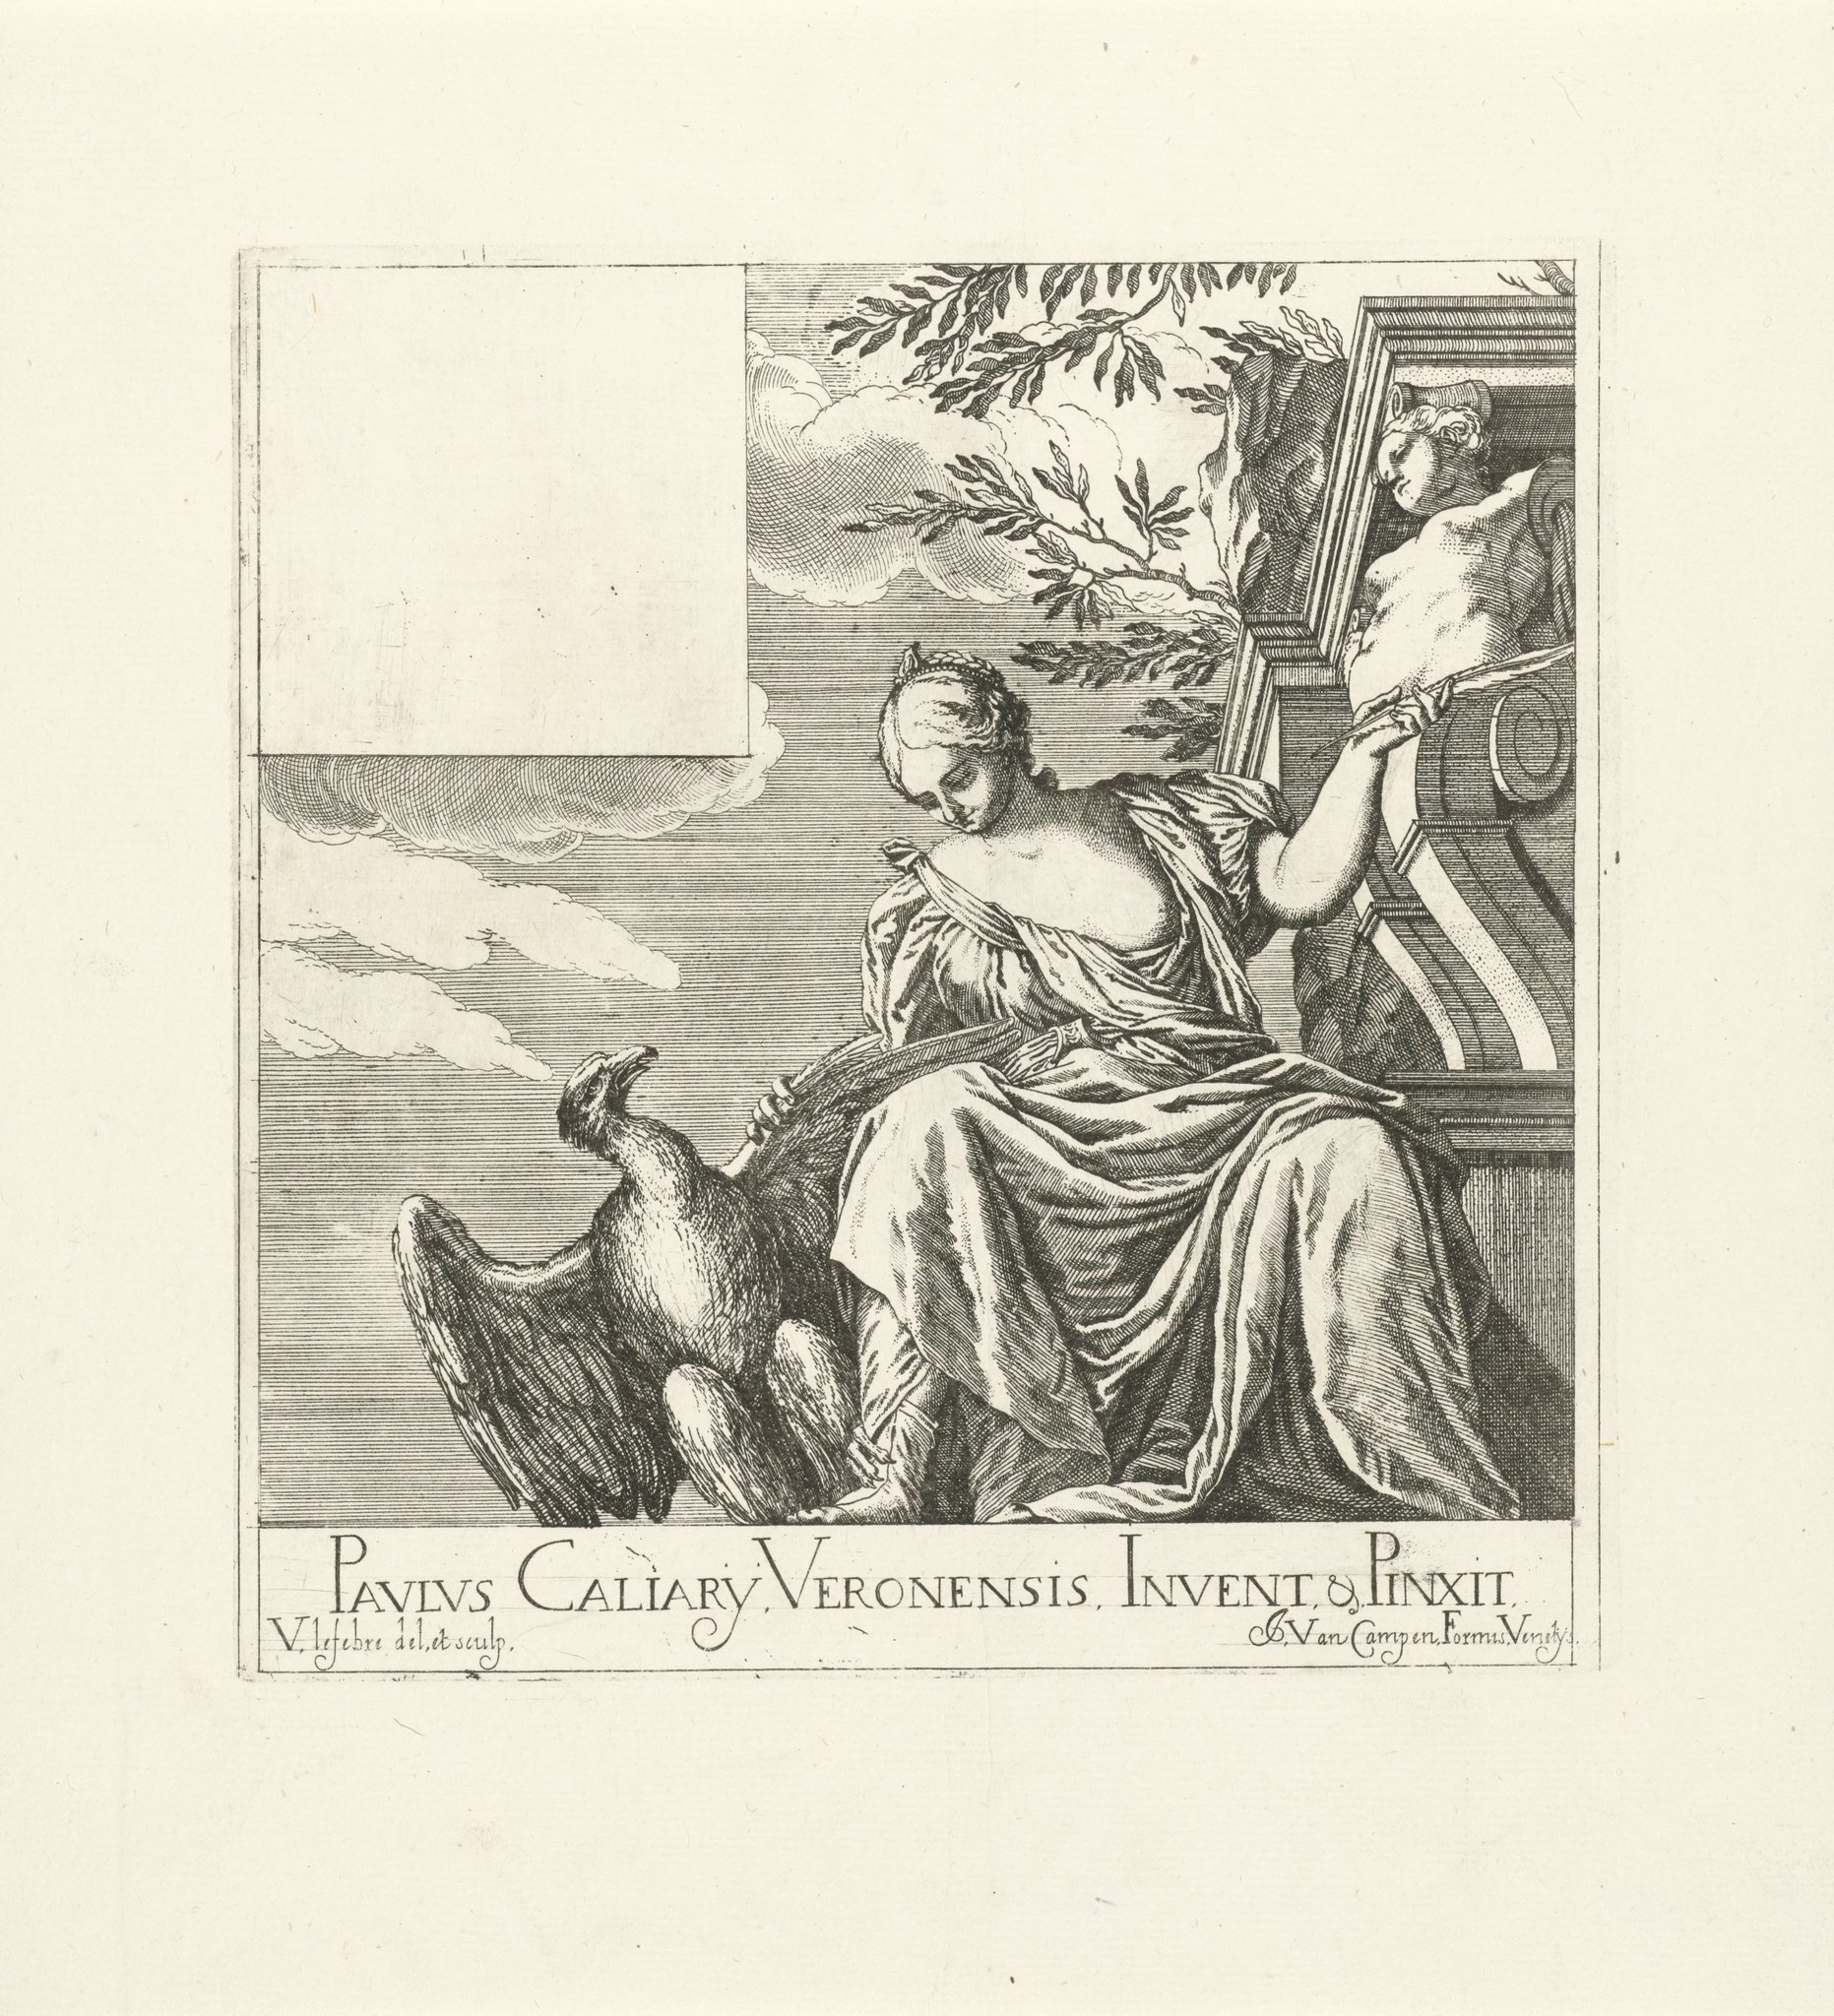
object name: print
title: Opera Selectiora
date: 1682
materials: paper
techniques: etching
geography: venice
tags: predatory birds: eagle, temperance, moderation; 'misura' (ripa)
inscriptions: collector's mark: Lugt 2228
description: De gepersonifieerde matigheid (Temperantia) zit bij een tempel en trekt veren van de adelaar naast haar. De prent maakt deel uit van een 53-delige serie prenten naar schilderijen van Titiaan en Veronese.